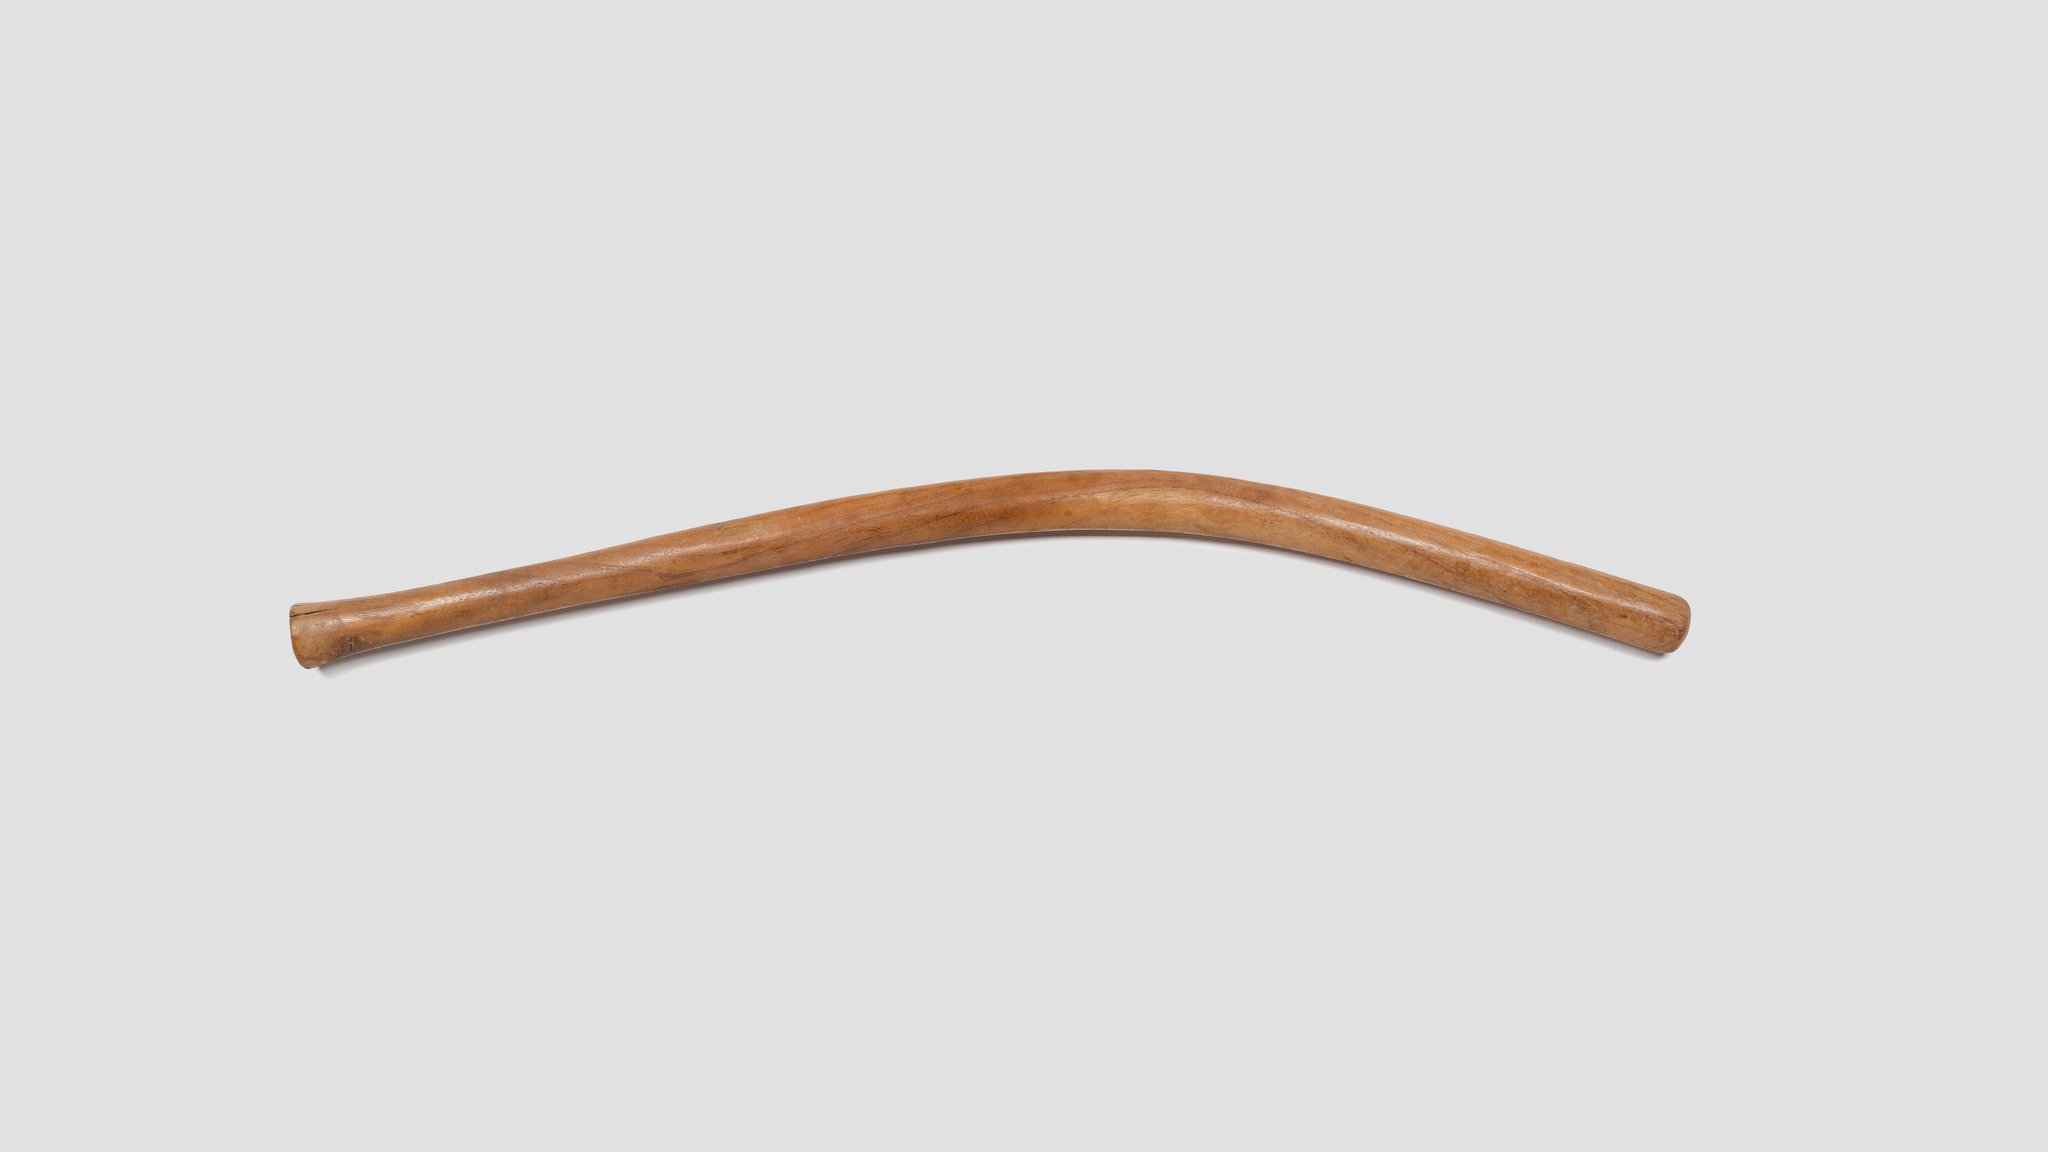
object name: throw stick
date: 1981-1802 BCE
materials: wood